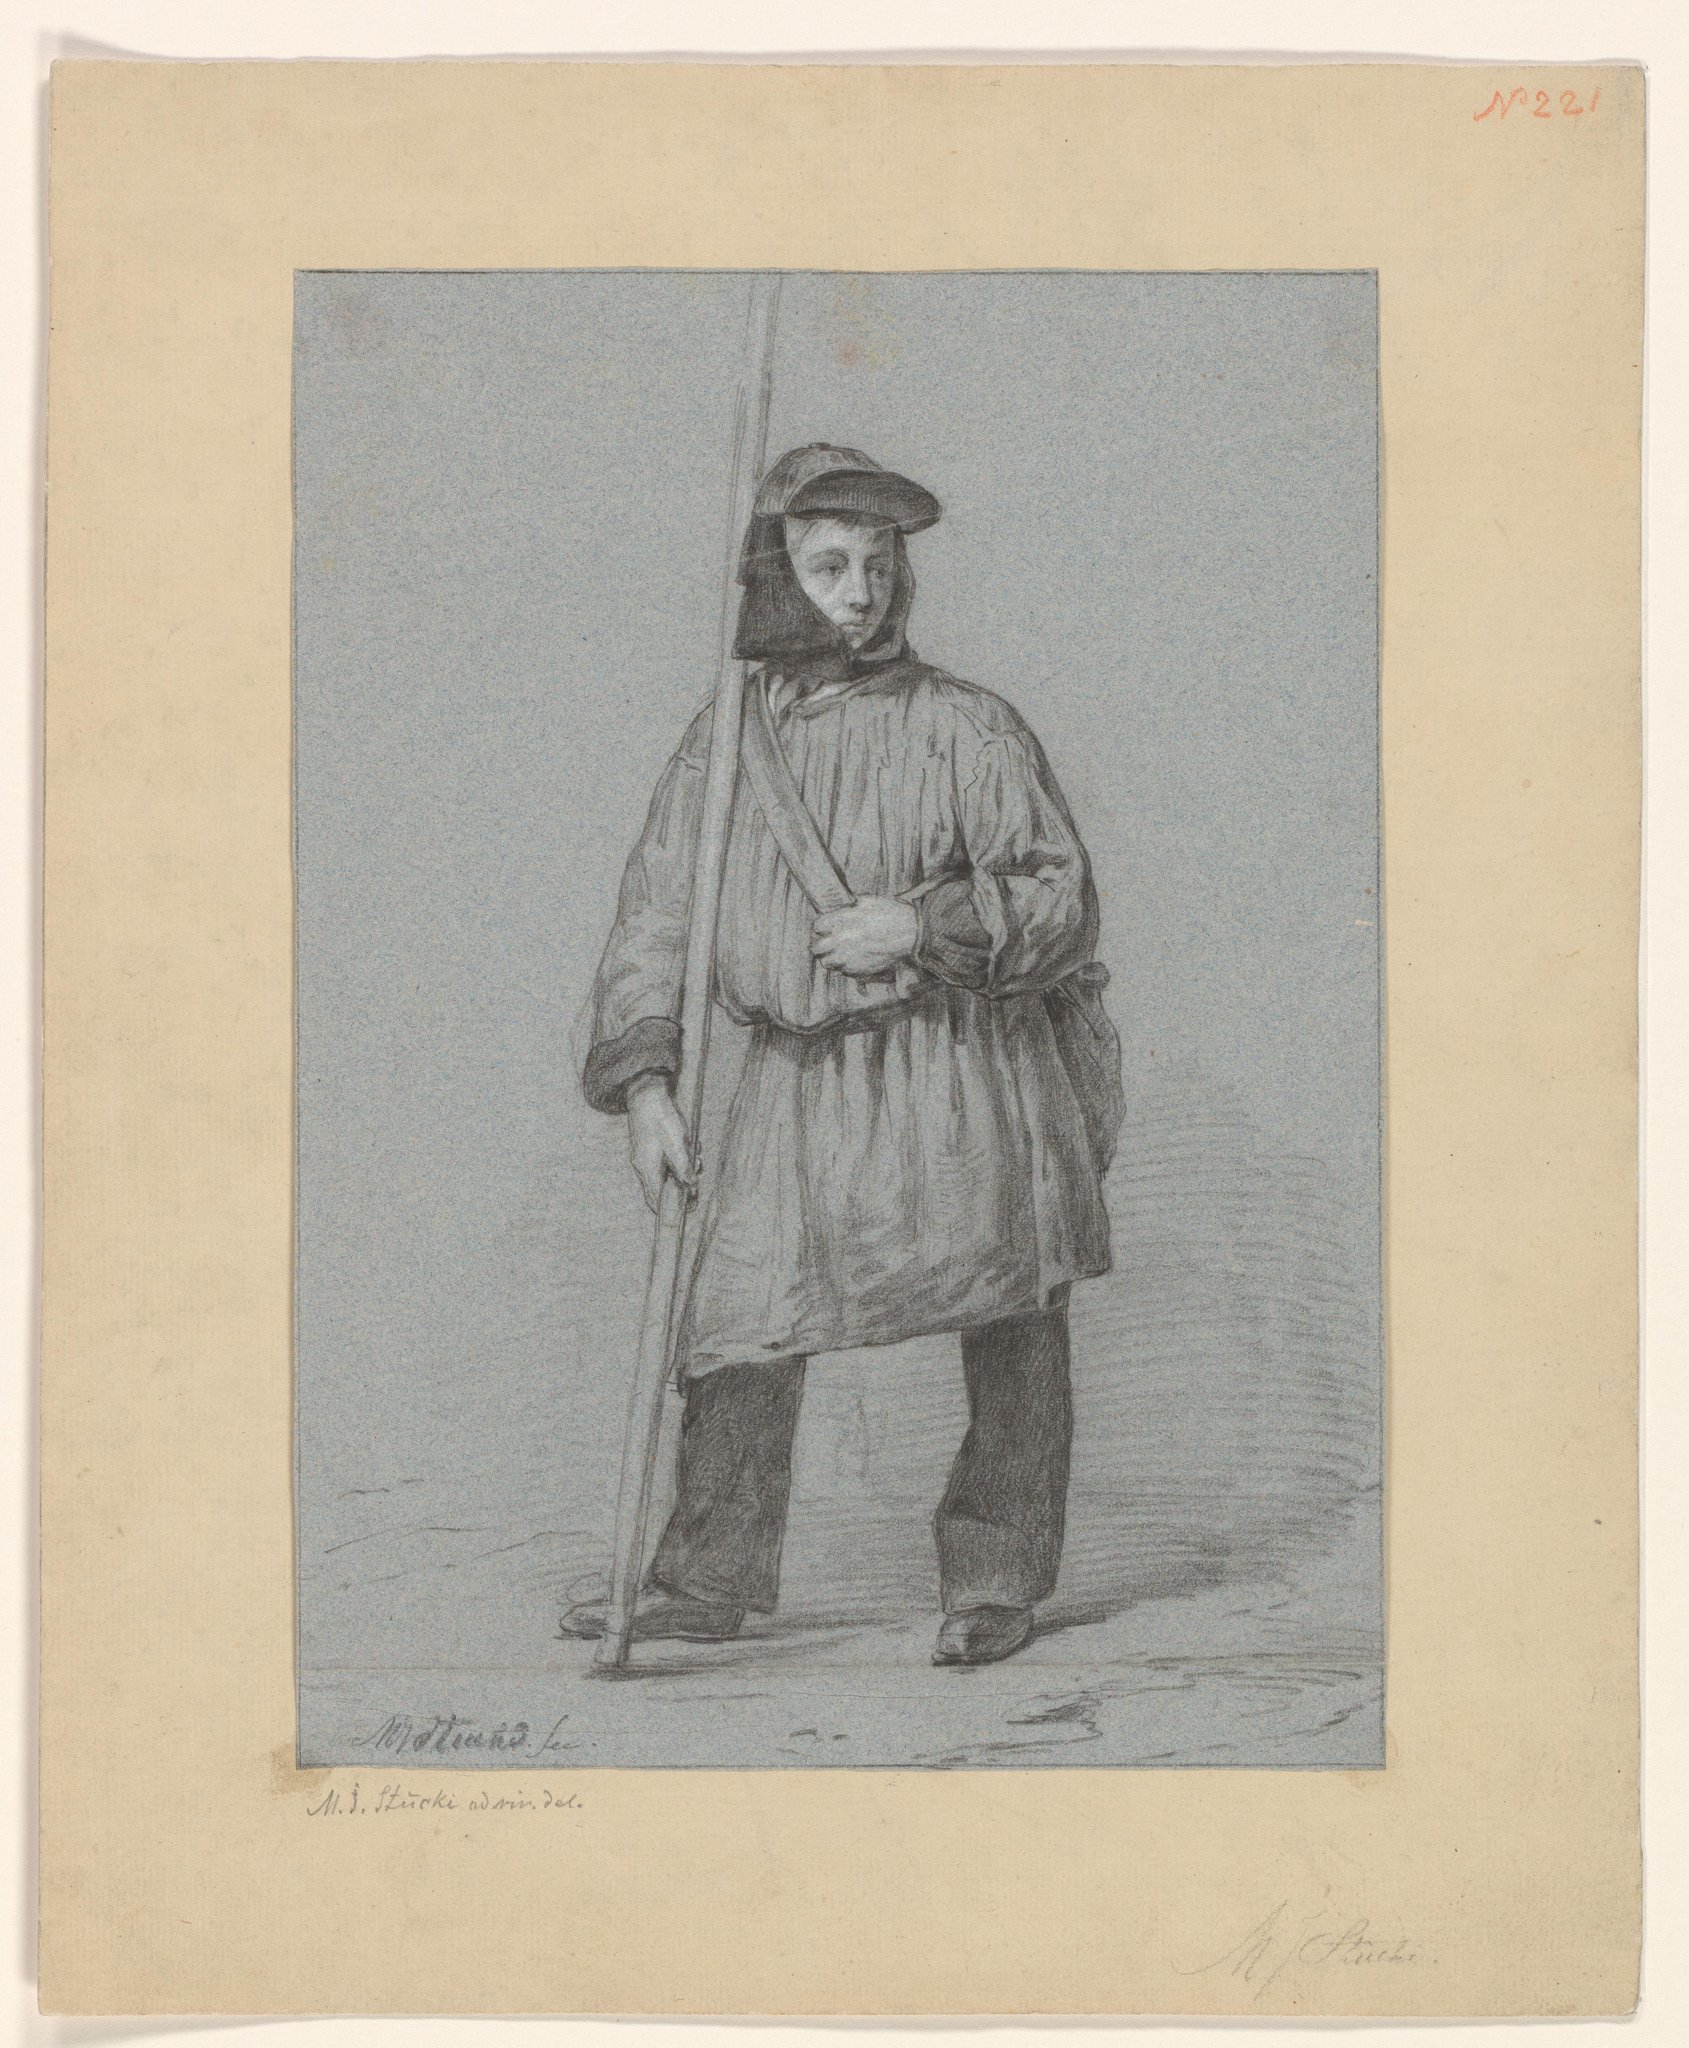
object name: drawing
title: Staande jongen met stok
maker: marinus jacobus stucki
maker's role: draughtsman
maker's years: 1809-1899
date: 1819-1899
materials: chalk, paper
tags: standing figure, boy (child between toddler and youth)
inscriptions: number: ‘No 221’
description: De jongen draagt een schoudertas en heeft een pet met zijflappen op het hoofd.